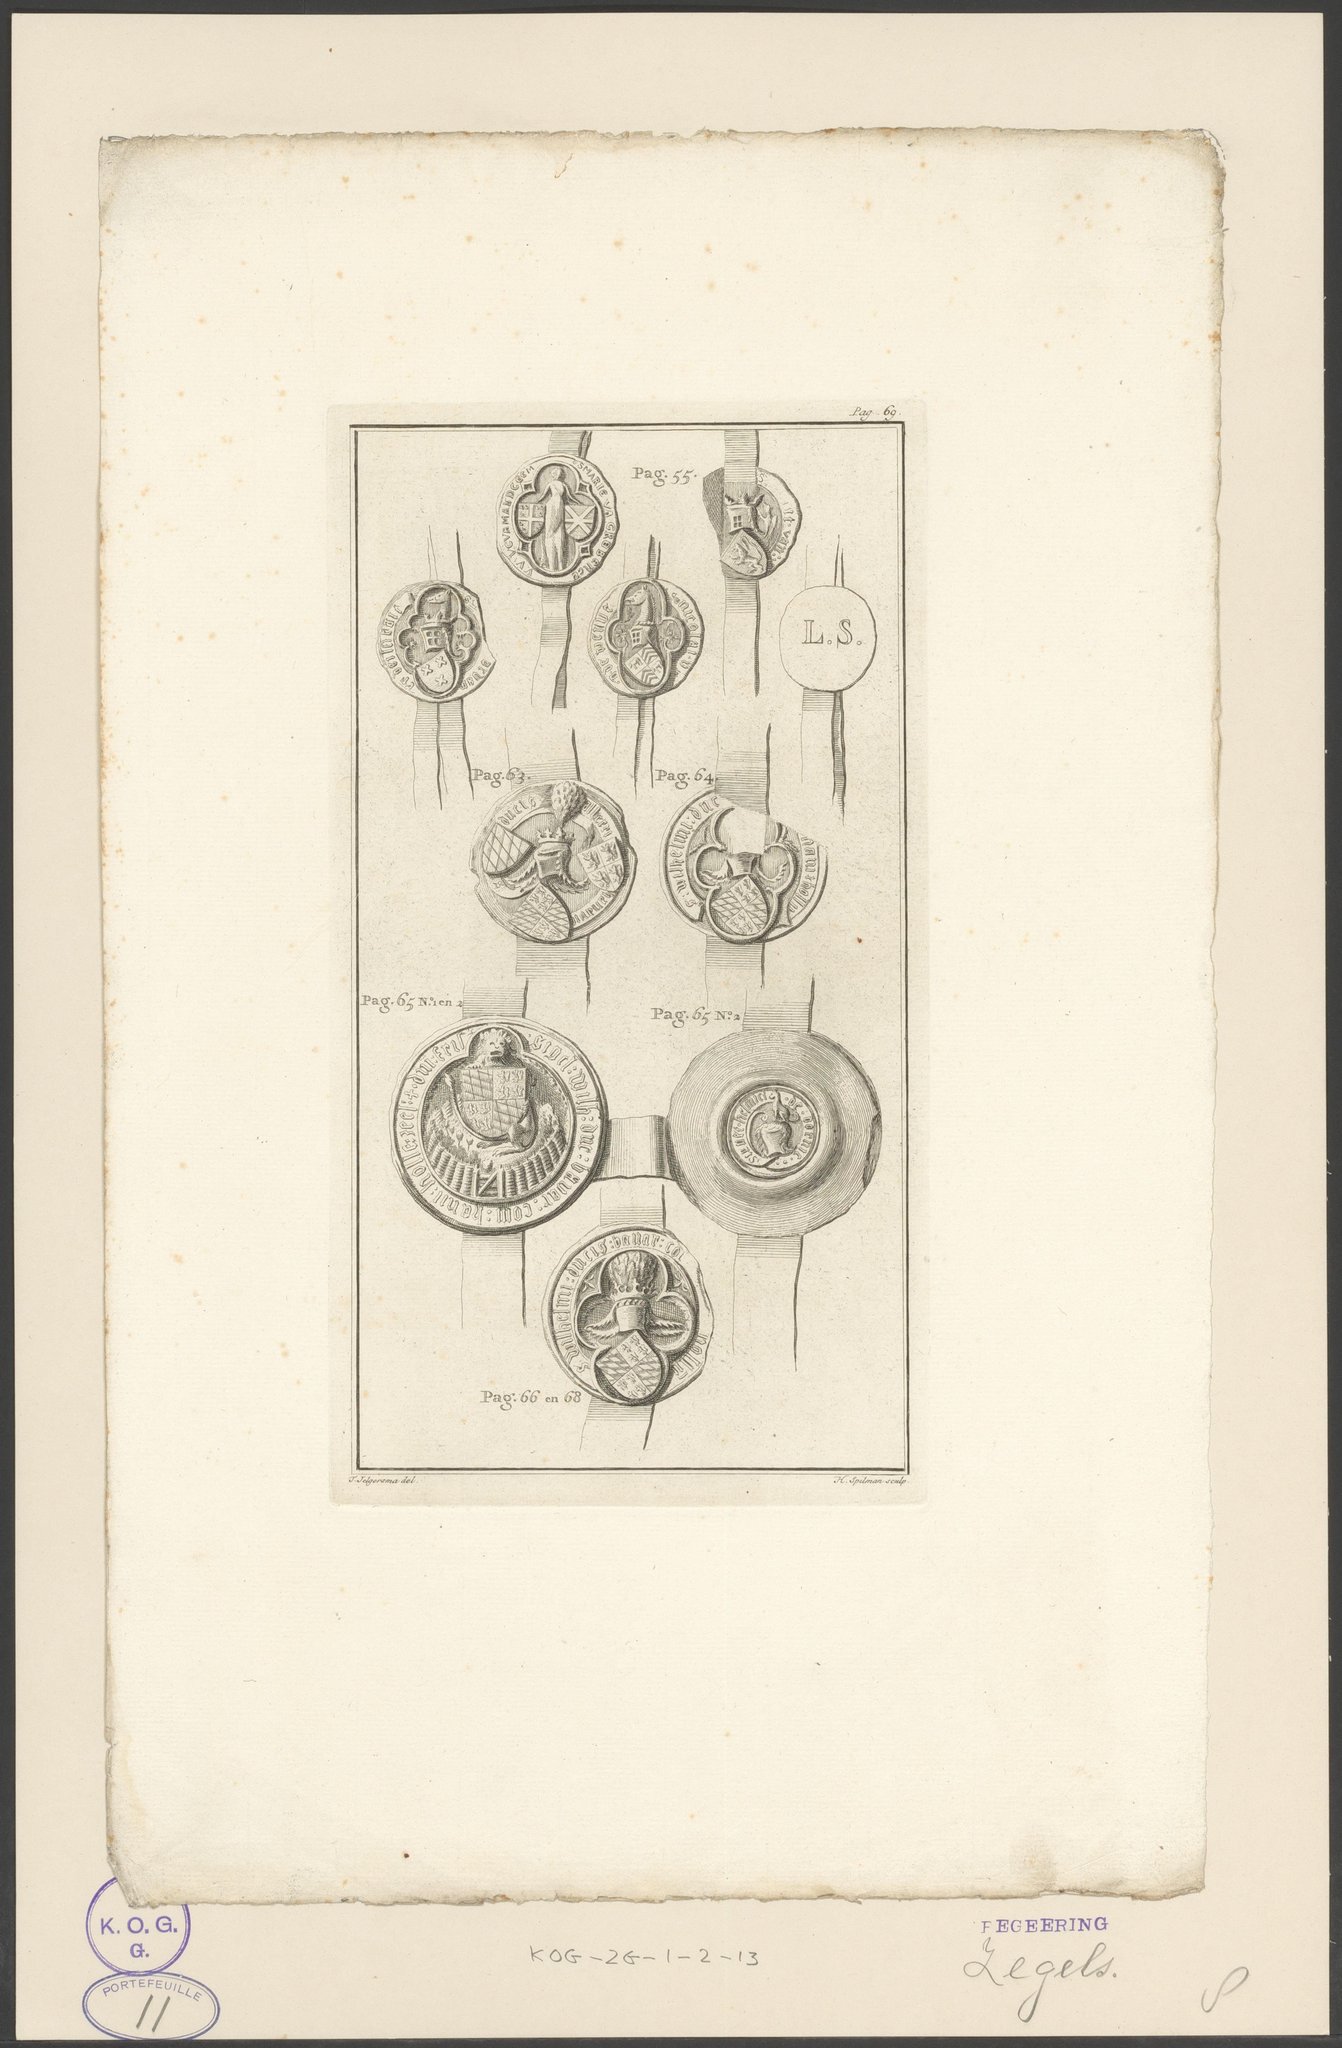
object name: print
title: Blad met zegels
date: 1751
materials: paper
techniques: etching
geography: netherlands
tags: seal, stamp, seal (as symbol of the state, etc.)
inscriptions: collector's mark, collector's mark: Lugt 1641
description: Diverse zegels, Pag. 69. Met verwijzingen naar andere nummers en paginanummers. Onderwerpsrubrieken binnen de Atlas Zeden en Gewoonten: Regeering, Zegels.